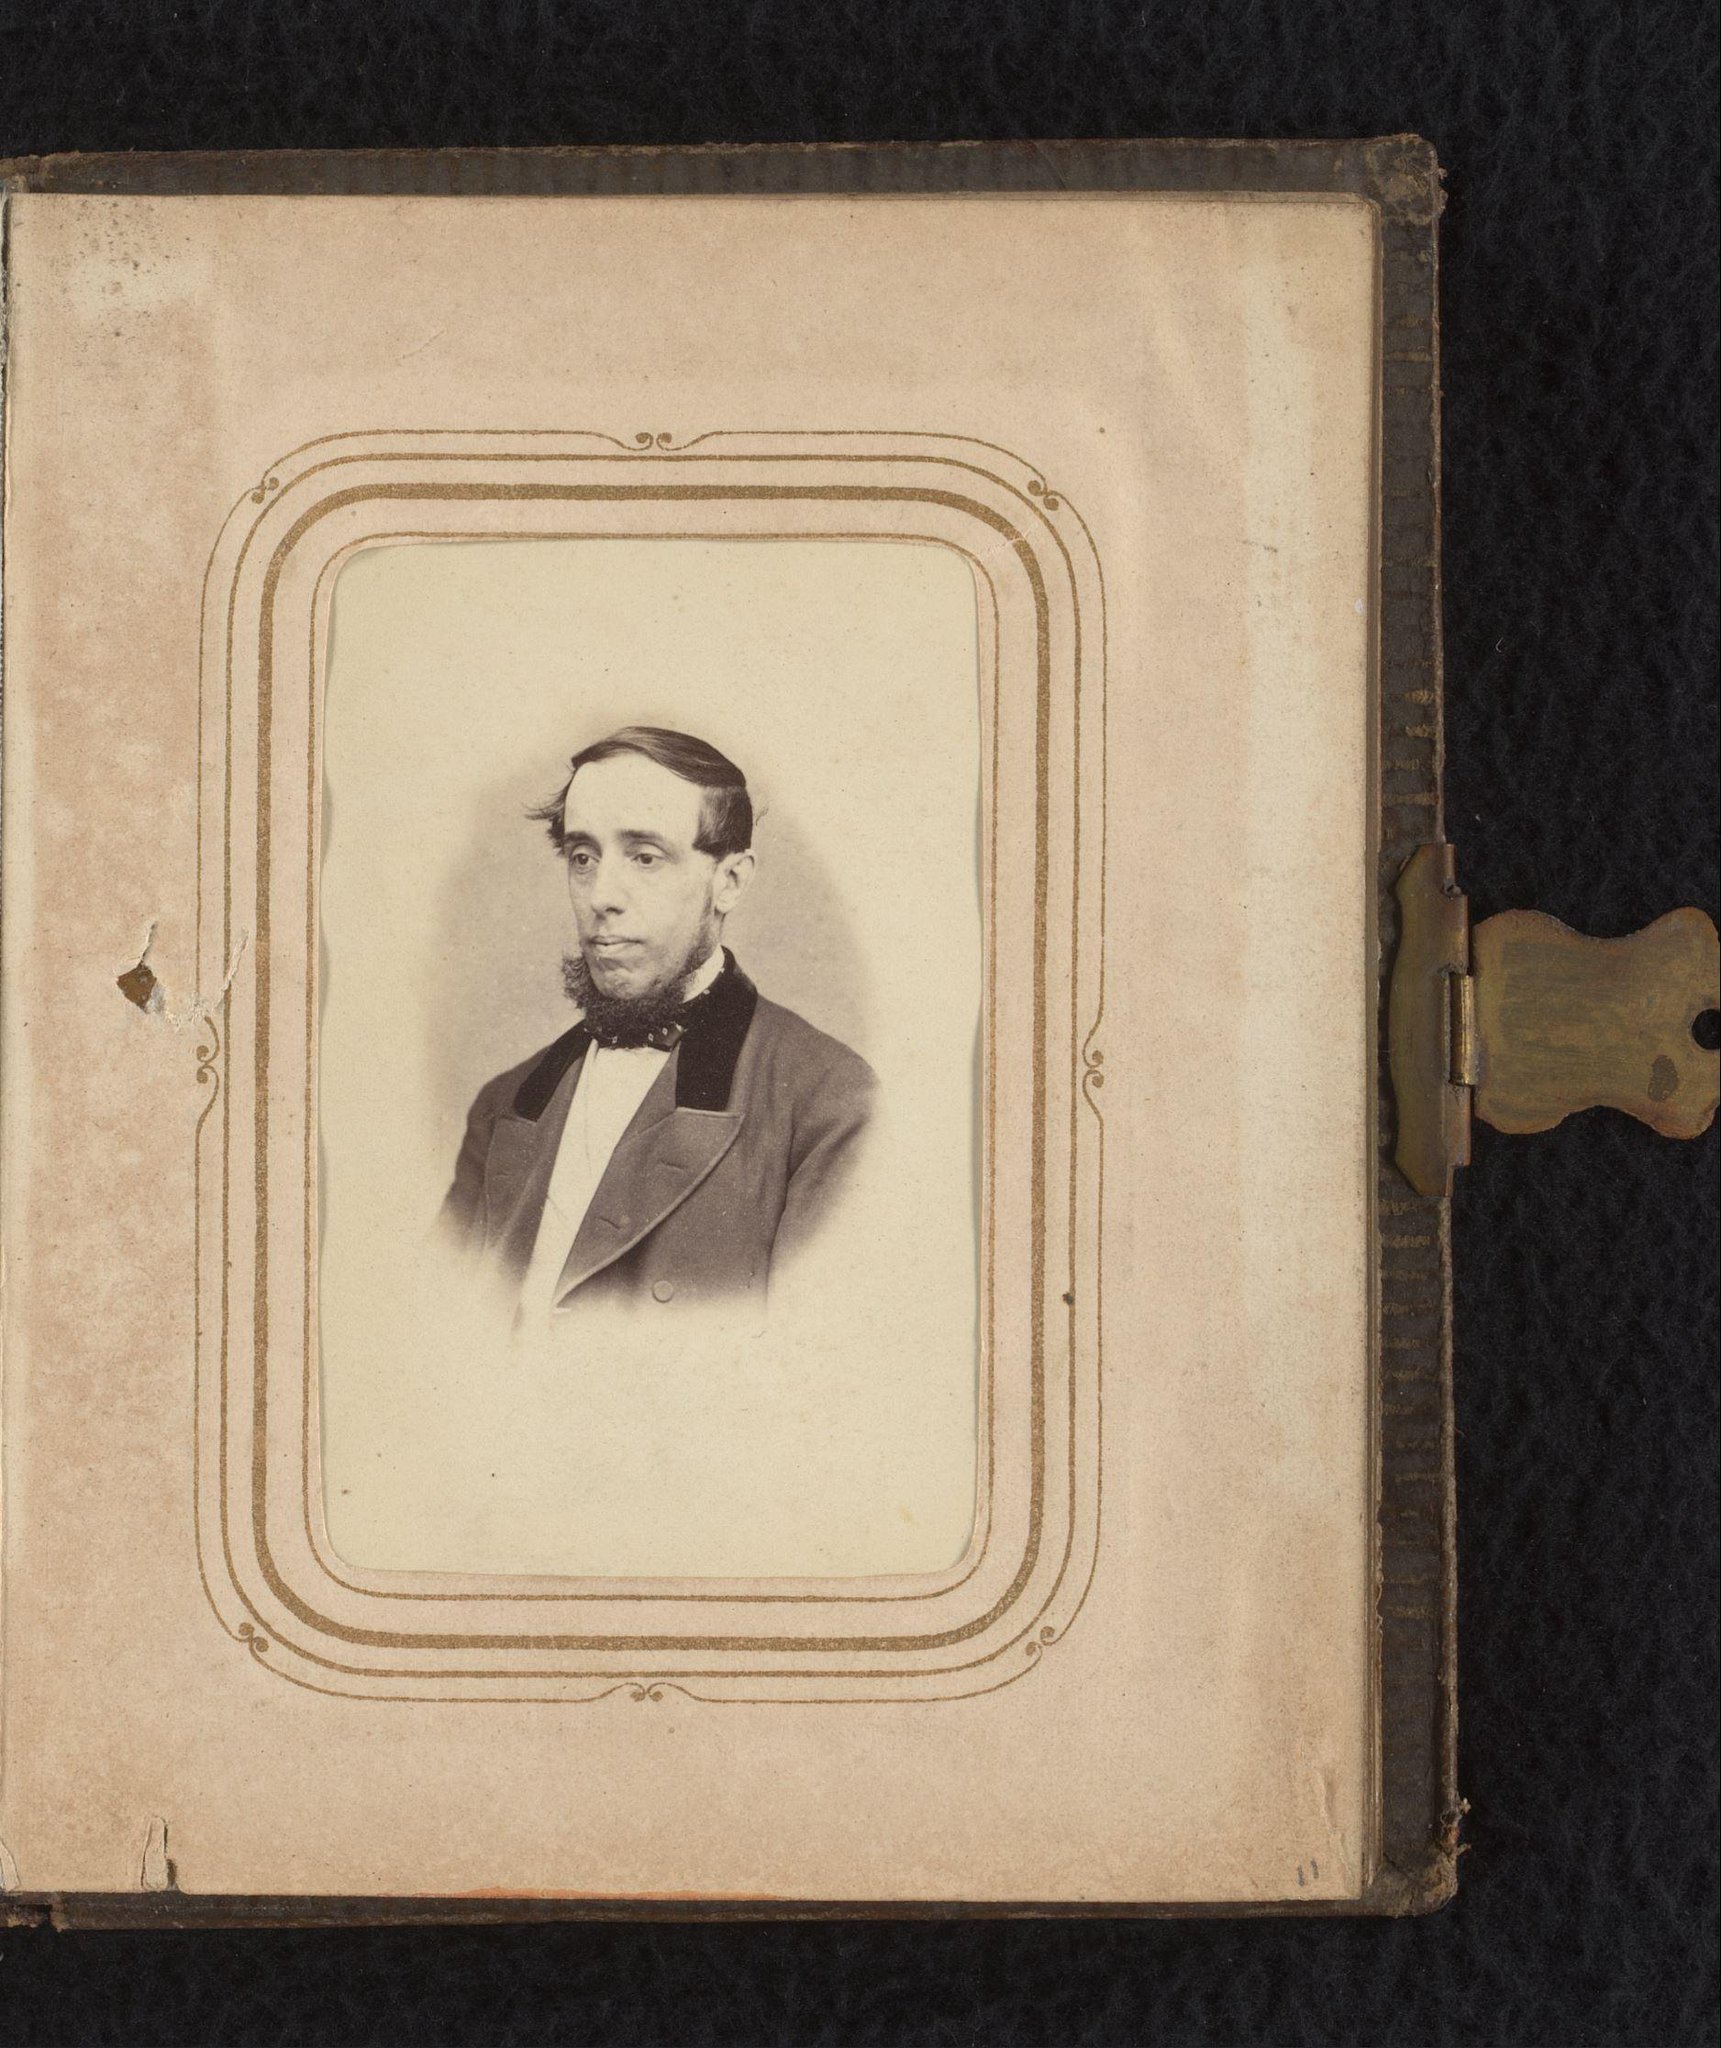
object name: photograph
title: Portret van een zittende man met baard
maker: harry thorn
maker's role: fotograaf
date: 1860-1900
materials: cardboard, photographic support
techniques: albumen print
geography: bude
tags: historical persons, beard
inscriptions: inscription: ‘H. Thorn/ Photographer/ Bude Haven’